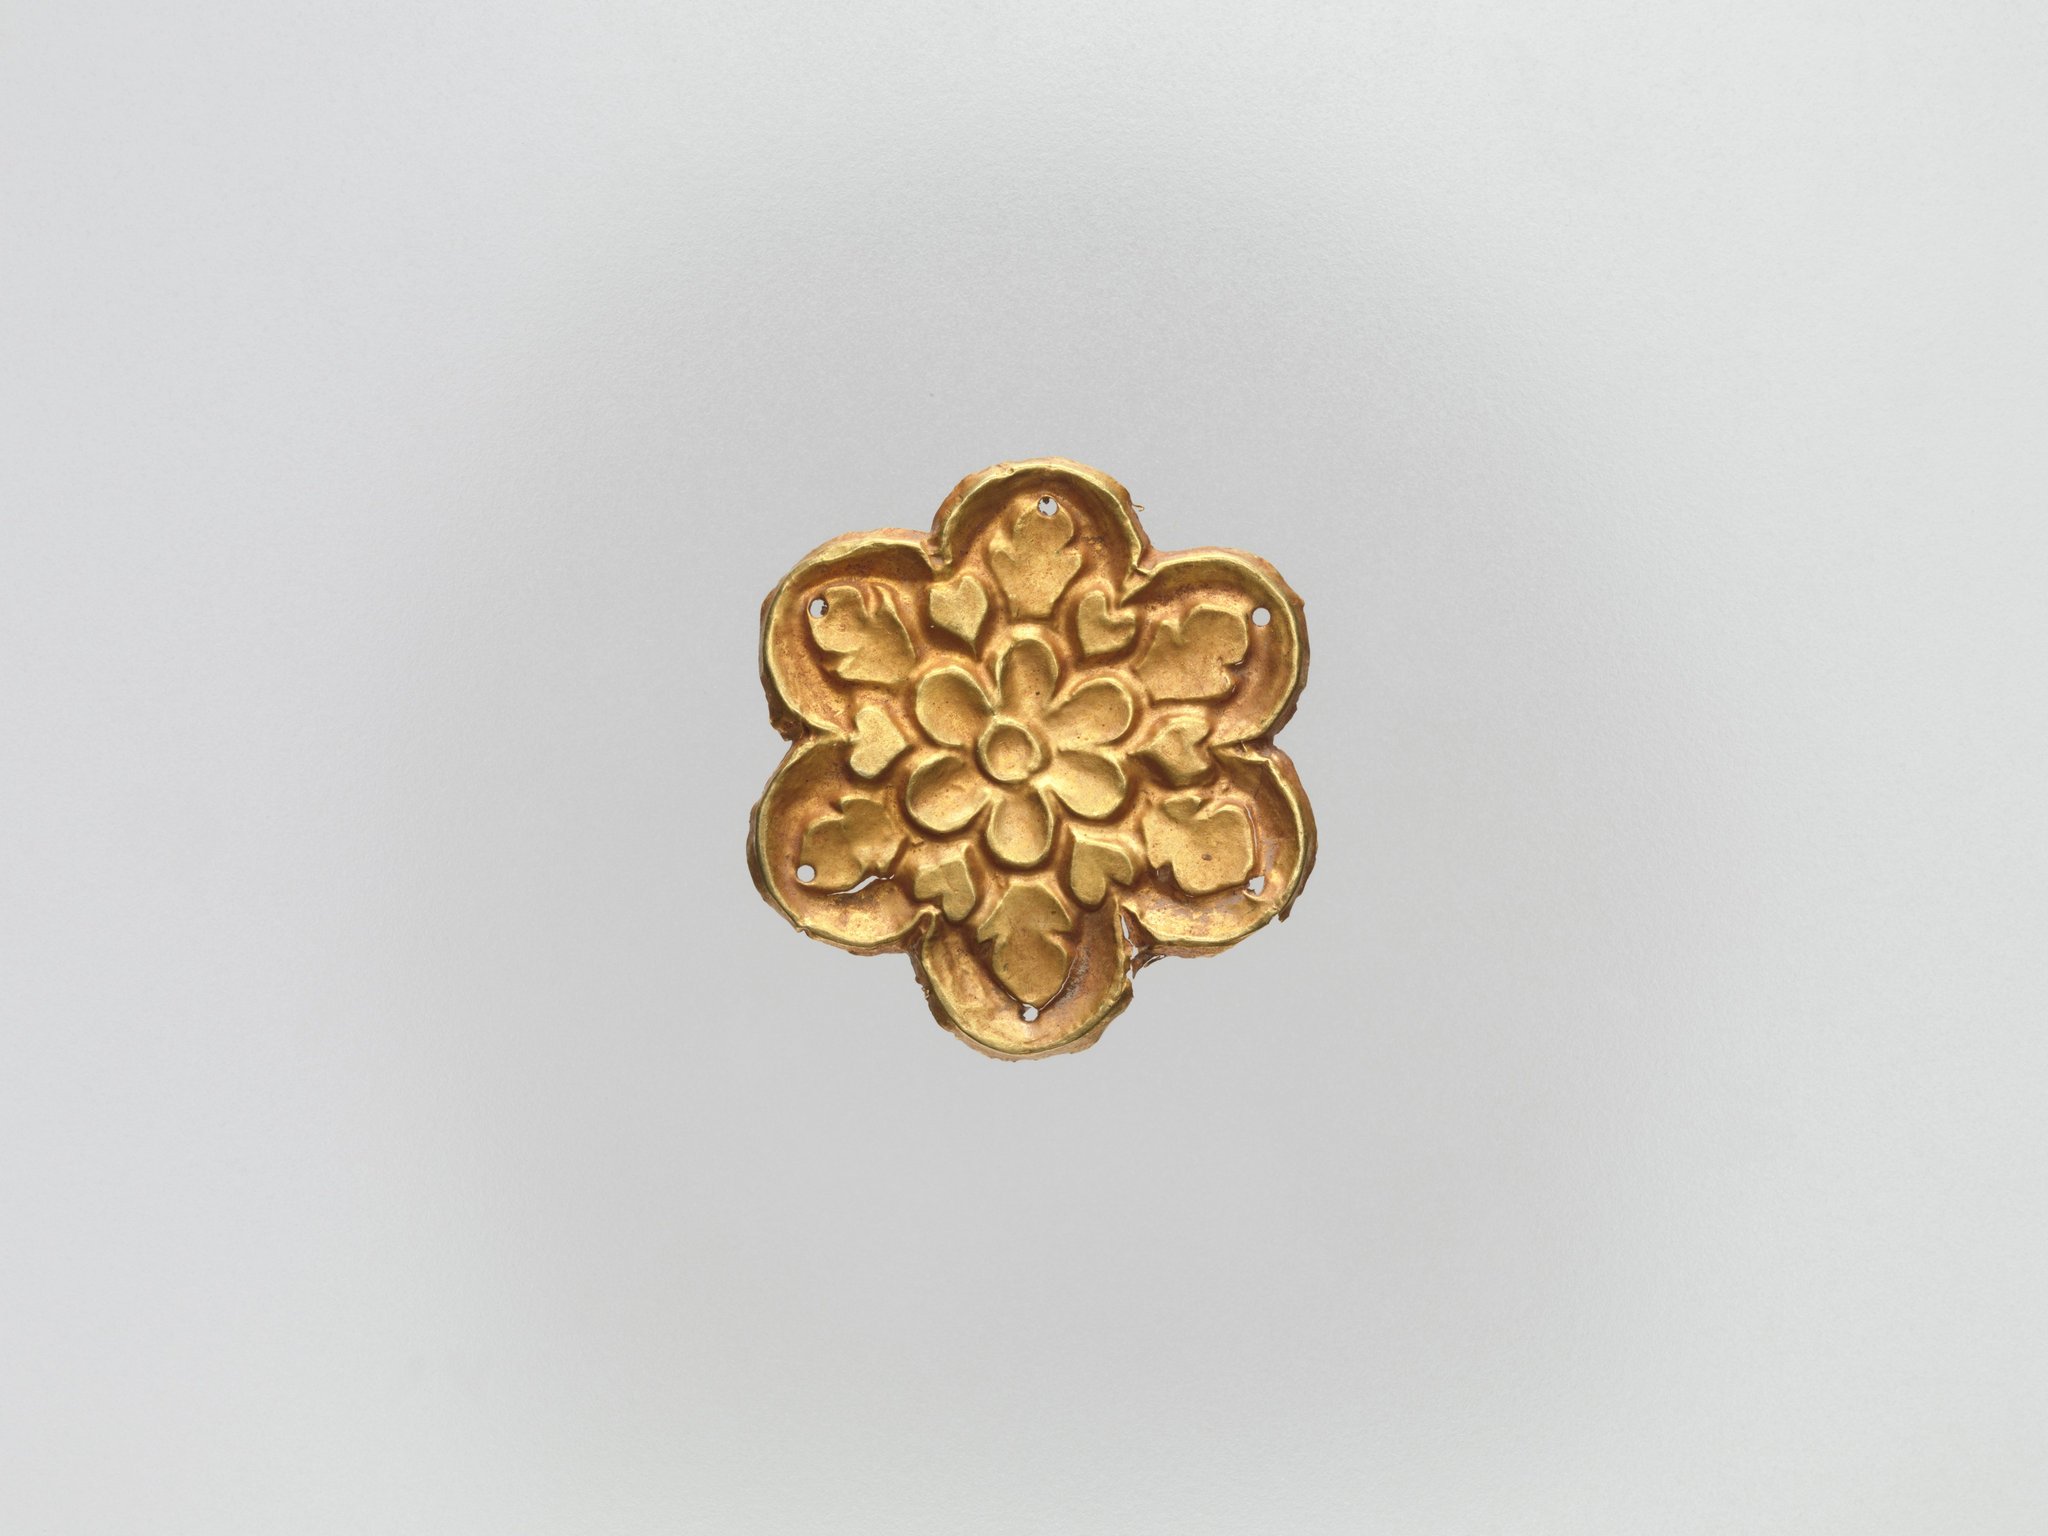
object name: garment plaque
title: Flower-Shaped Clothing Plaque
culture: chinese or central asian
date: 601-900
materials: gold